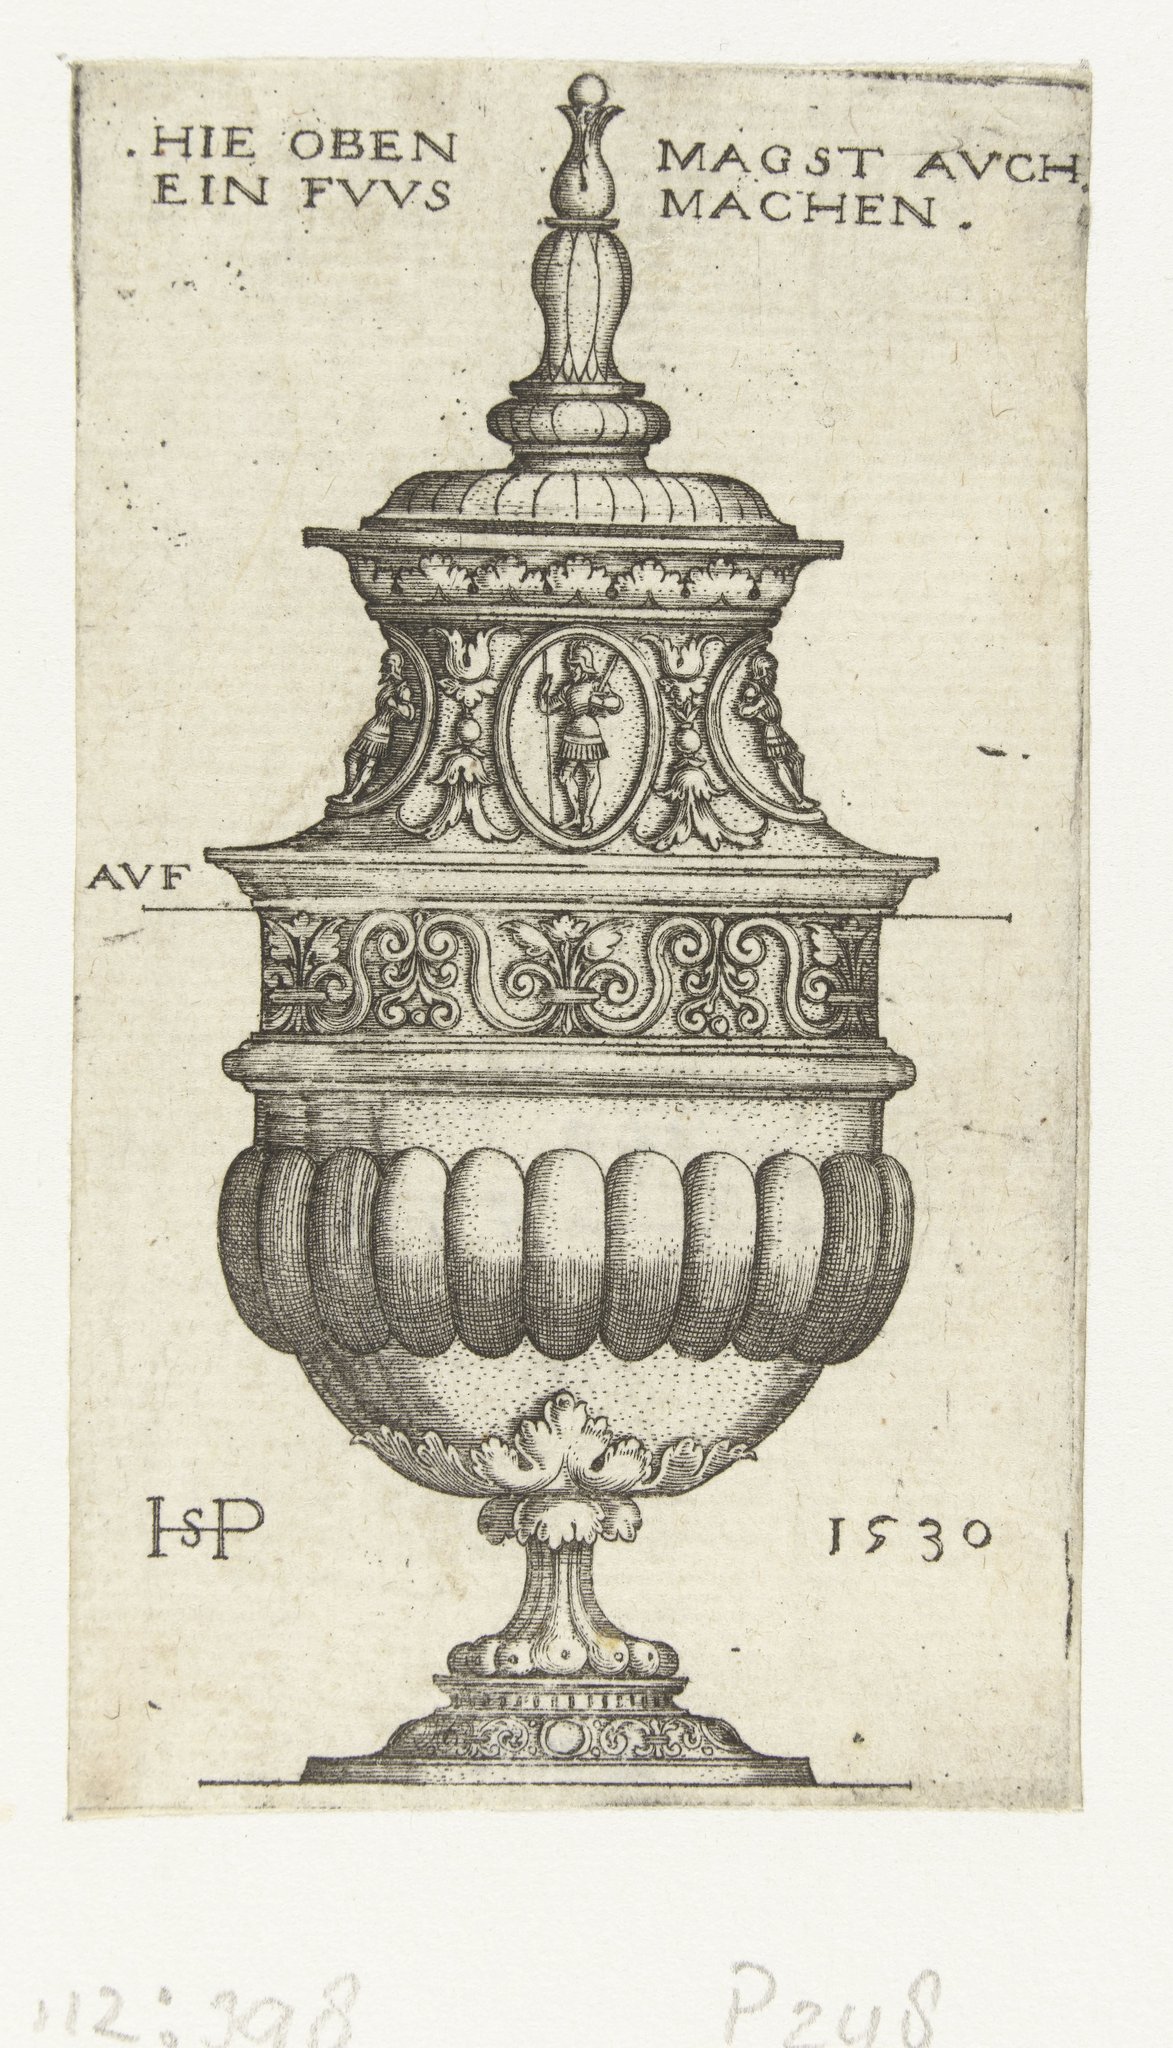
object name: ornament print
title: Vazen, gedecoreerd met medaillons, geometrische motieven en bladeren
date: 1510-1530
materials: paper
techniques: engraving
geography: germany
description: Bokaal met deksel, met inscriptie HIE OBEN MAGST SUCH EIN FVVS MACHEN. 1 van 3 bladen.